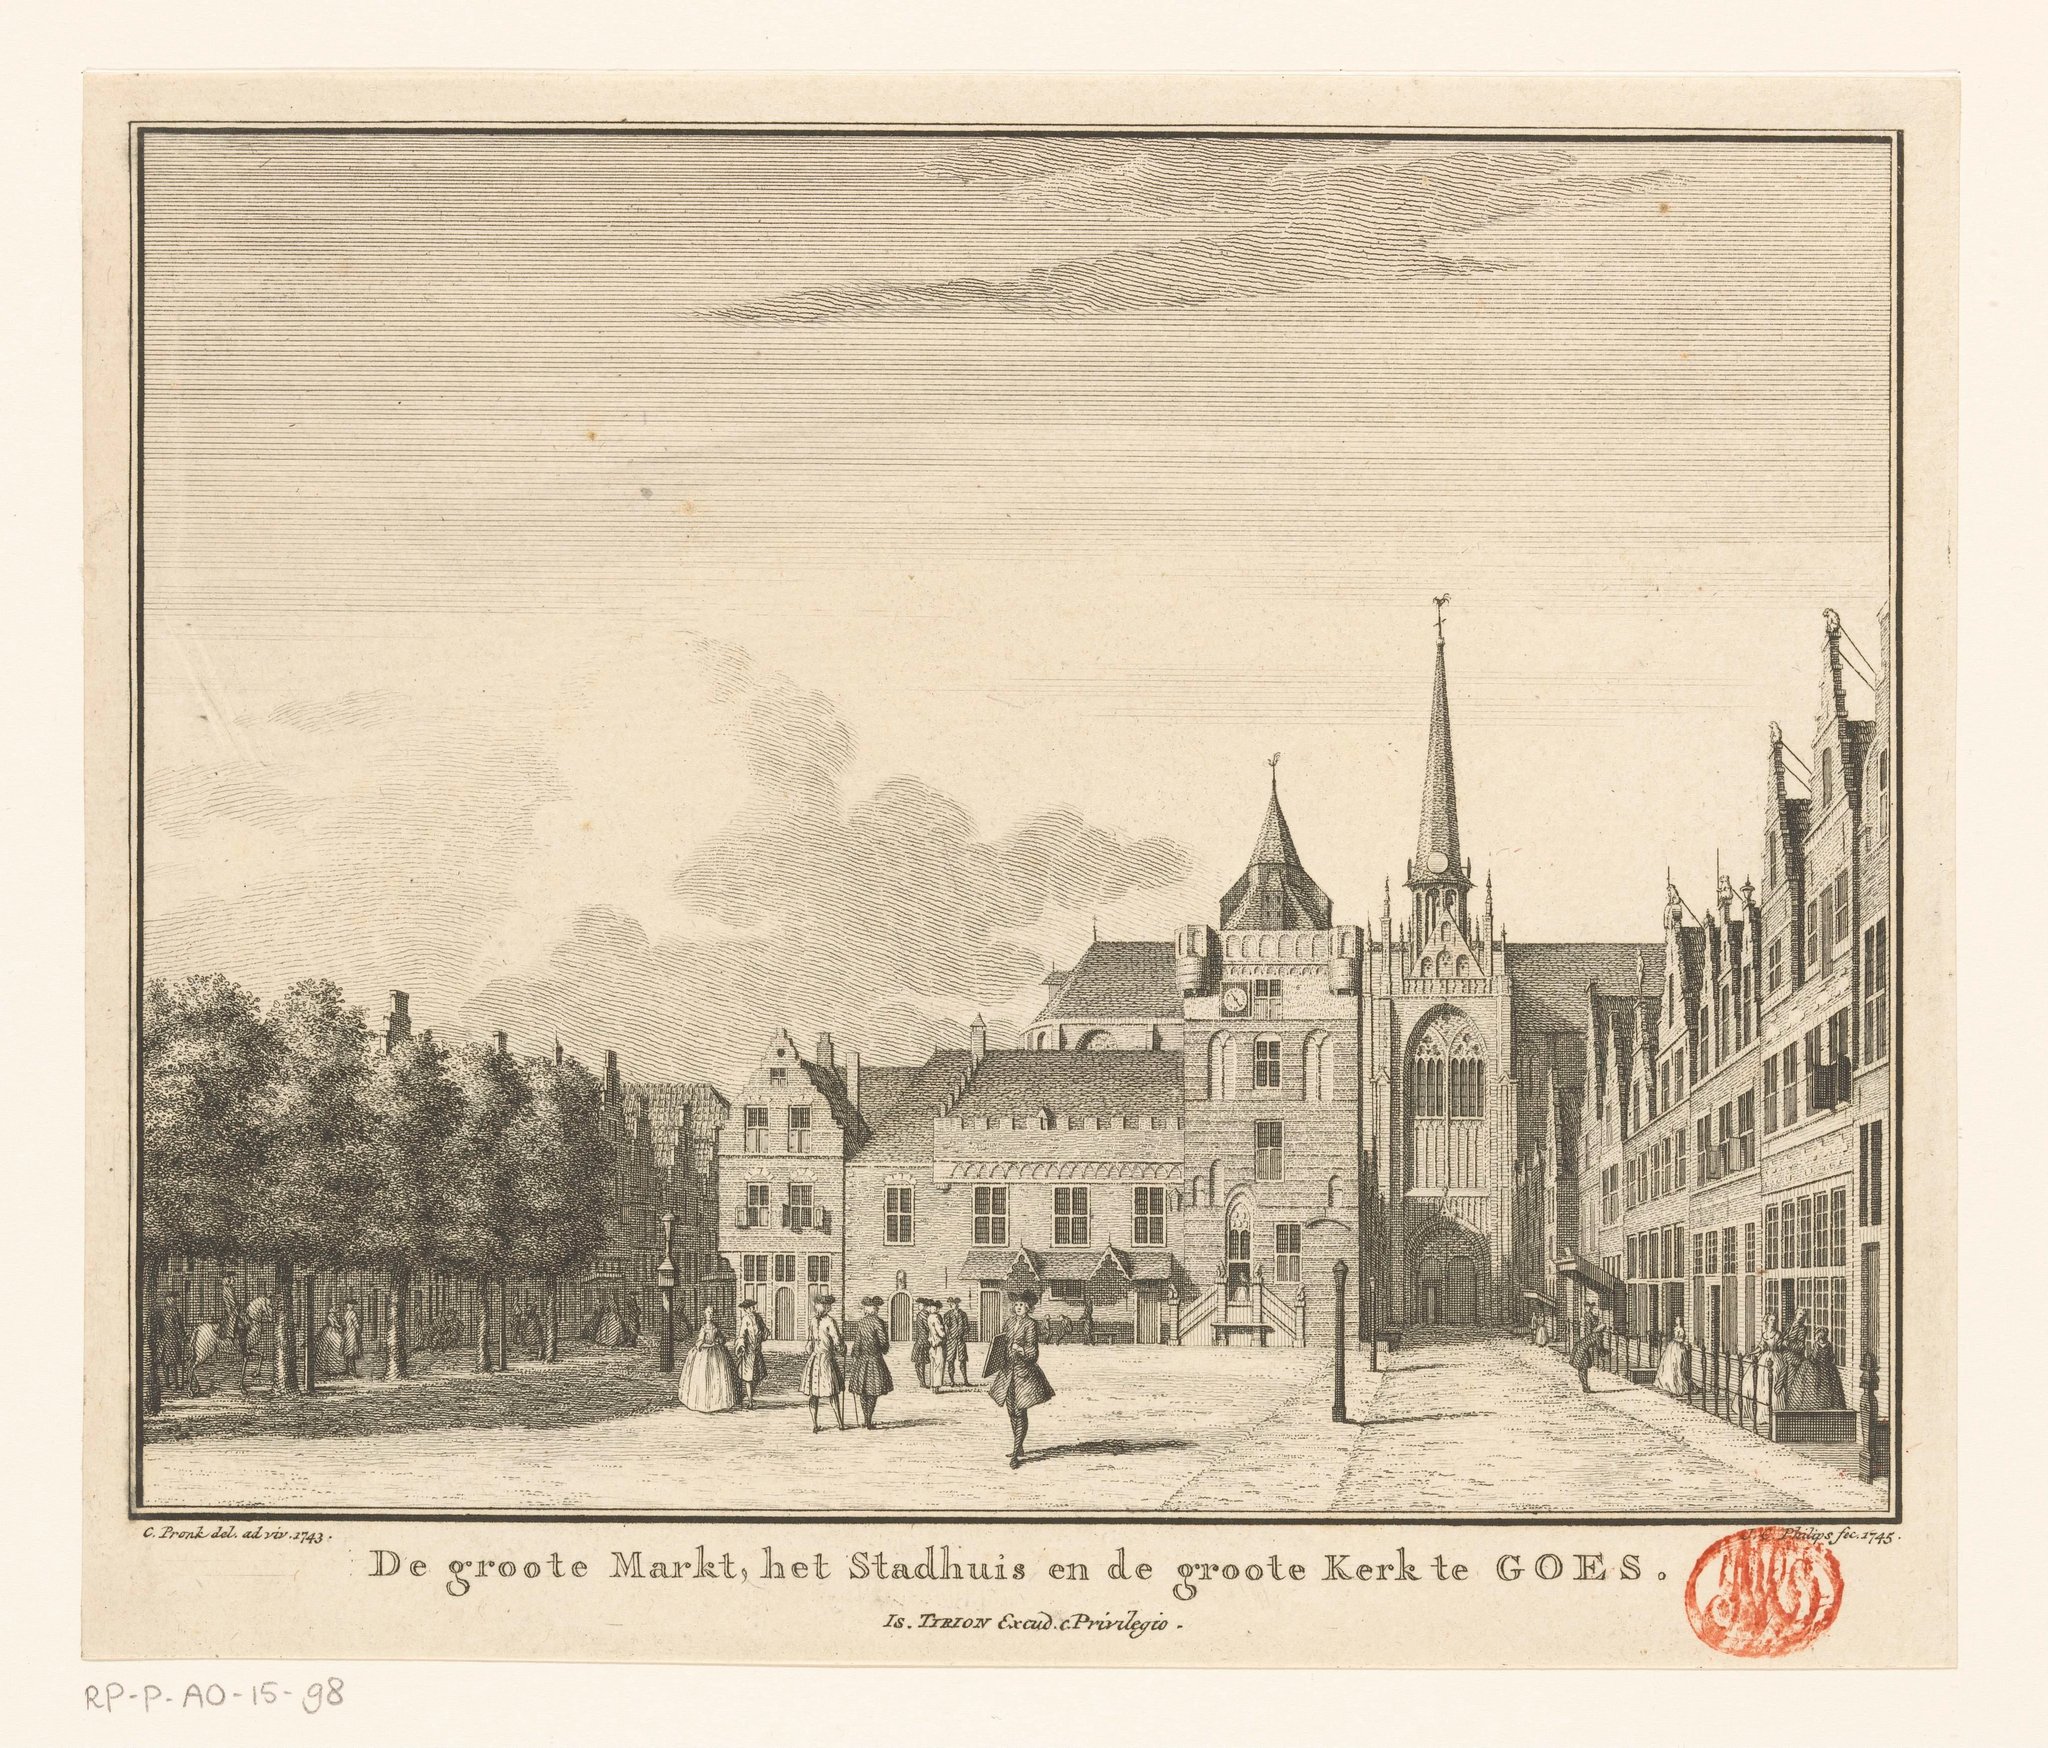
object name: book illustration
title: Gezicht op Goes, 1743 / Gezicht op de haven en Westerschans te Goes, 1743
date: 1753-1760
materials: paper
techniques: etching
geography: amsterdam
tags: harbour, prospect of city, town panorama, silhouette of city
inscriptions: collector's mark: Lugt 195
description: Boven een gezicht op Goes, gezien vanuit de haven. Onder een gezicht op de haven en Westerschans te Goes. In de situatie omstreeks 1743.